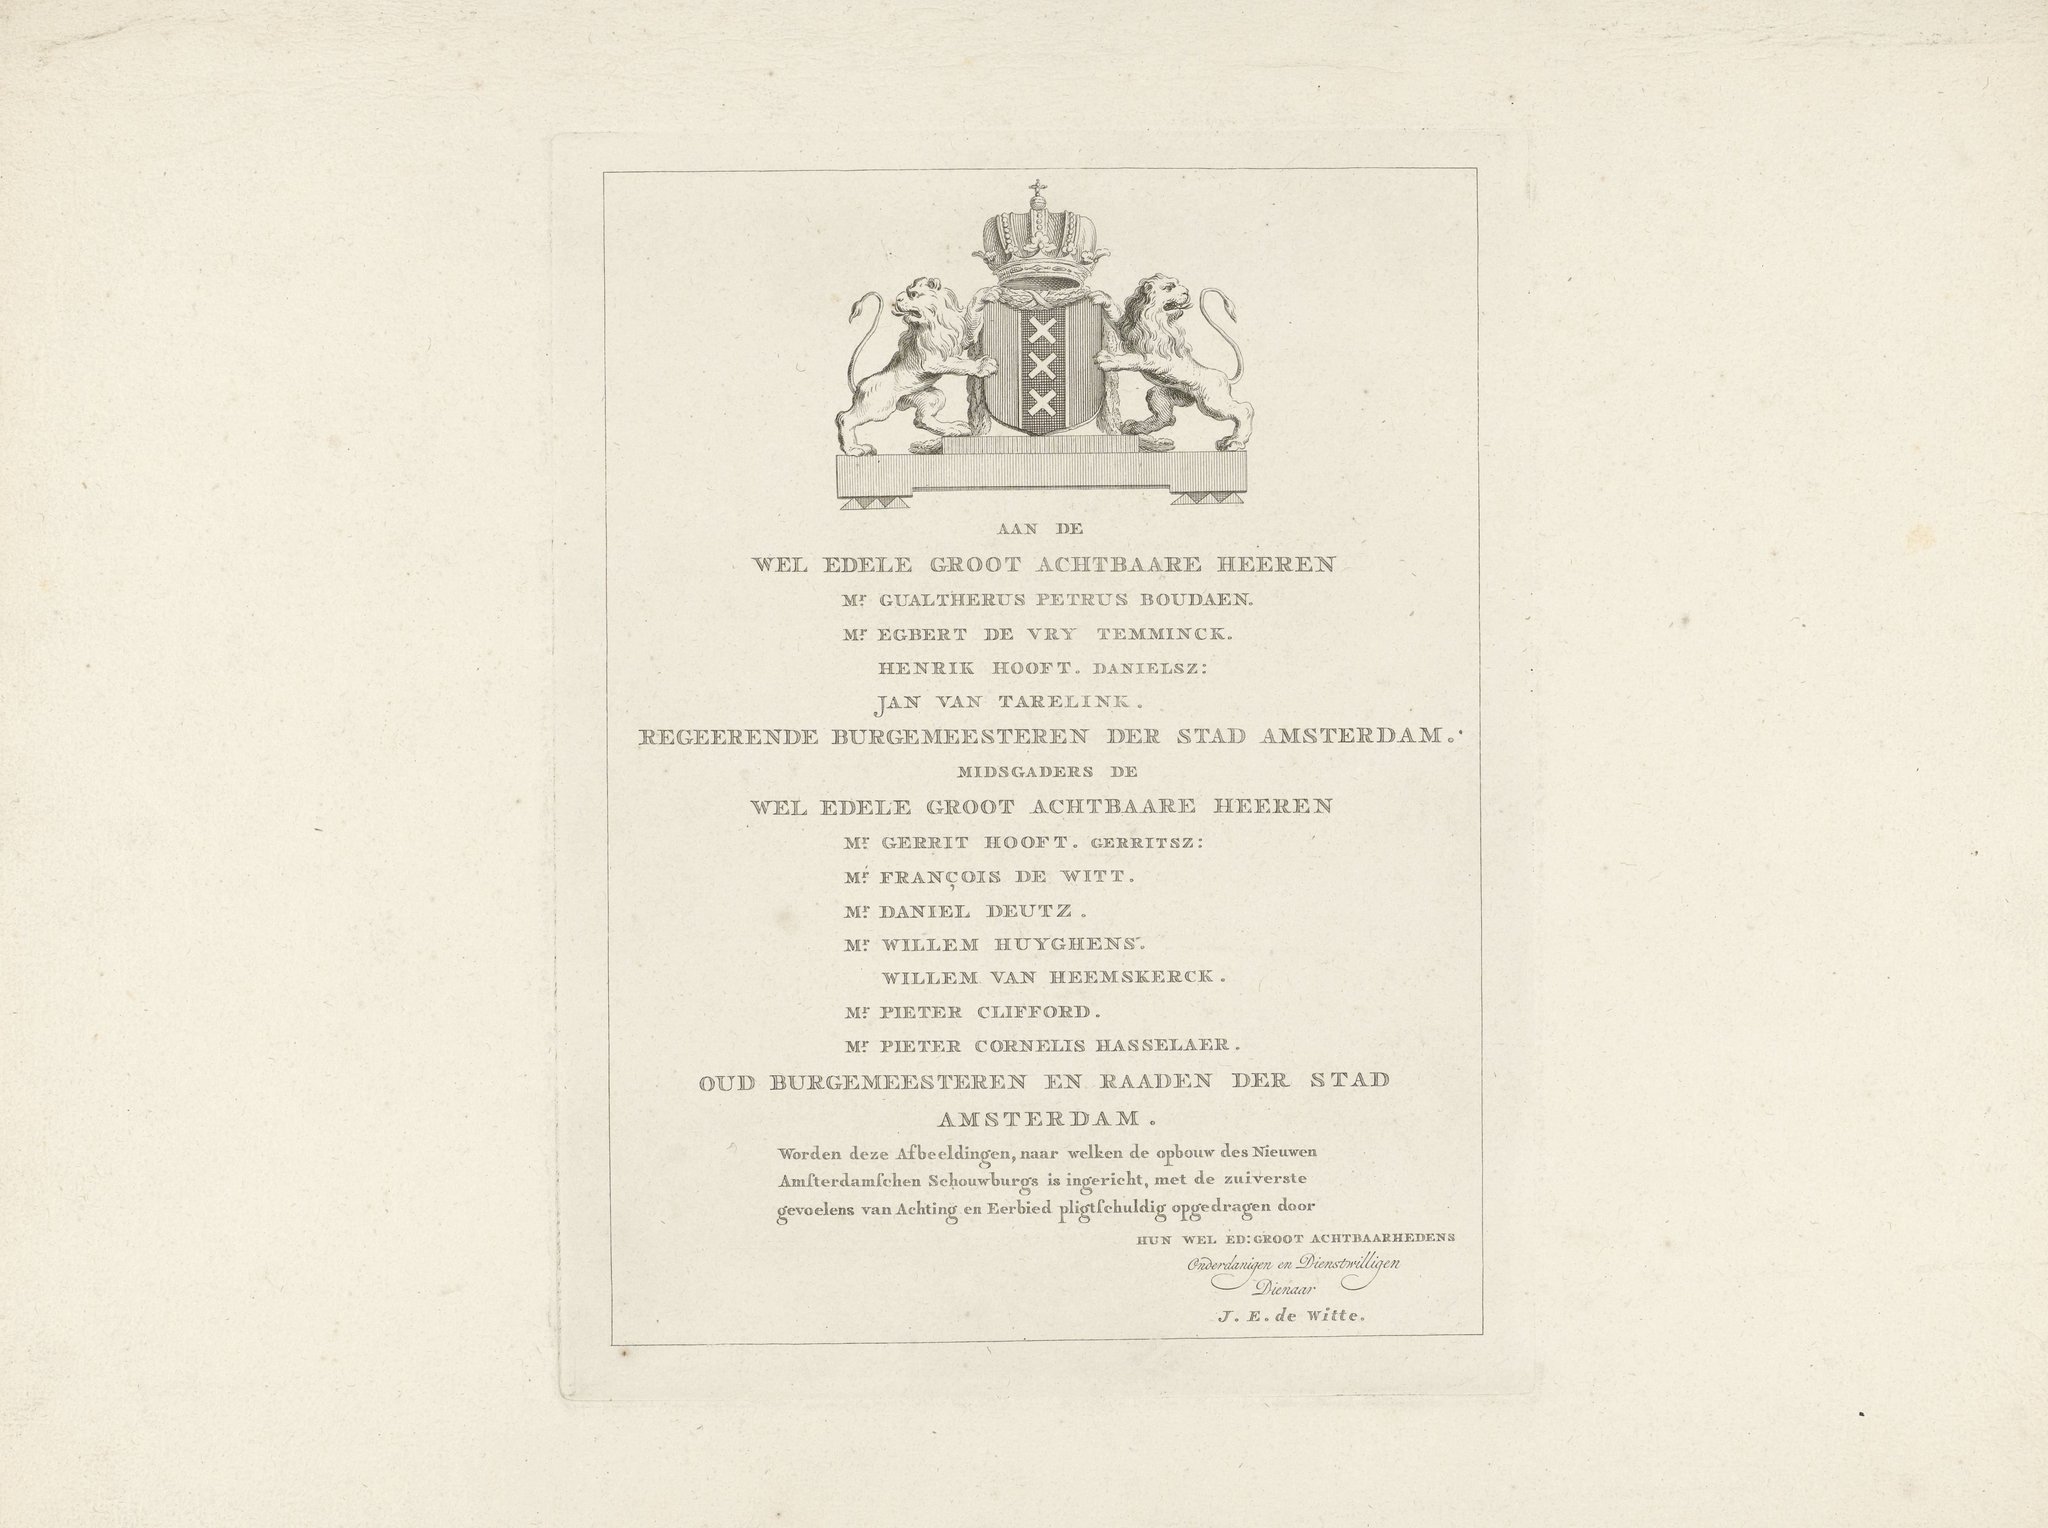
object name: print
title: Opdracht voor de prentreeks: Afbeeldingen van den Schouwburg te Amsterdam, 1774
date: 1774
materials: paper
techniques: etching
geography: amsterdam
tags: print maker, jacob eduard de witte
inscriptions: collector's mark: Lugt 2228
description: Opdracht aan de burgemeesters, oud-burgemeesters en raden van de stad Amsterdam van de prentreeks met veertien platen van de nieuwe Schouwburg te Amsterdam, 1774. Lijst van namen, bovenaan het stadswapen van Amsterdam.